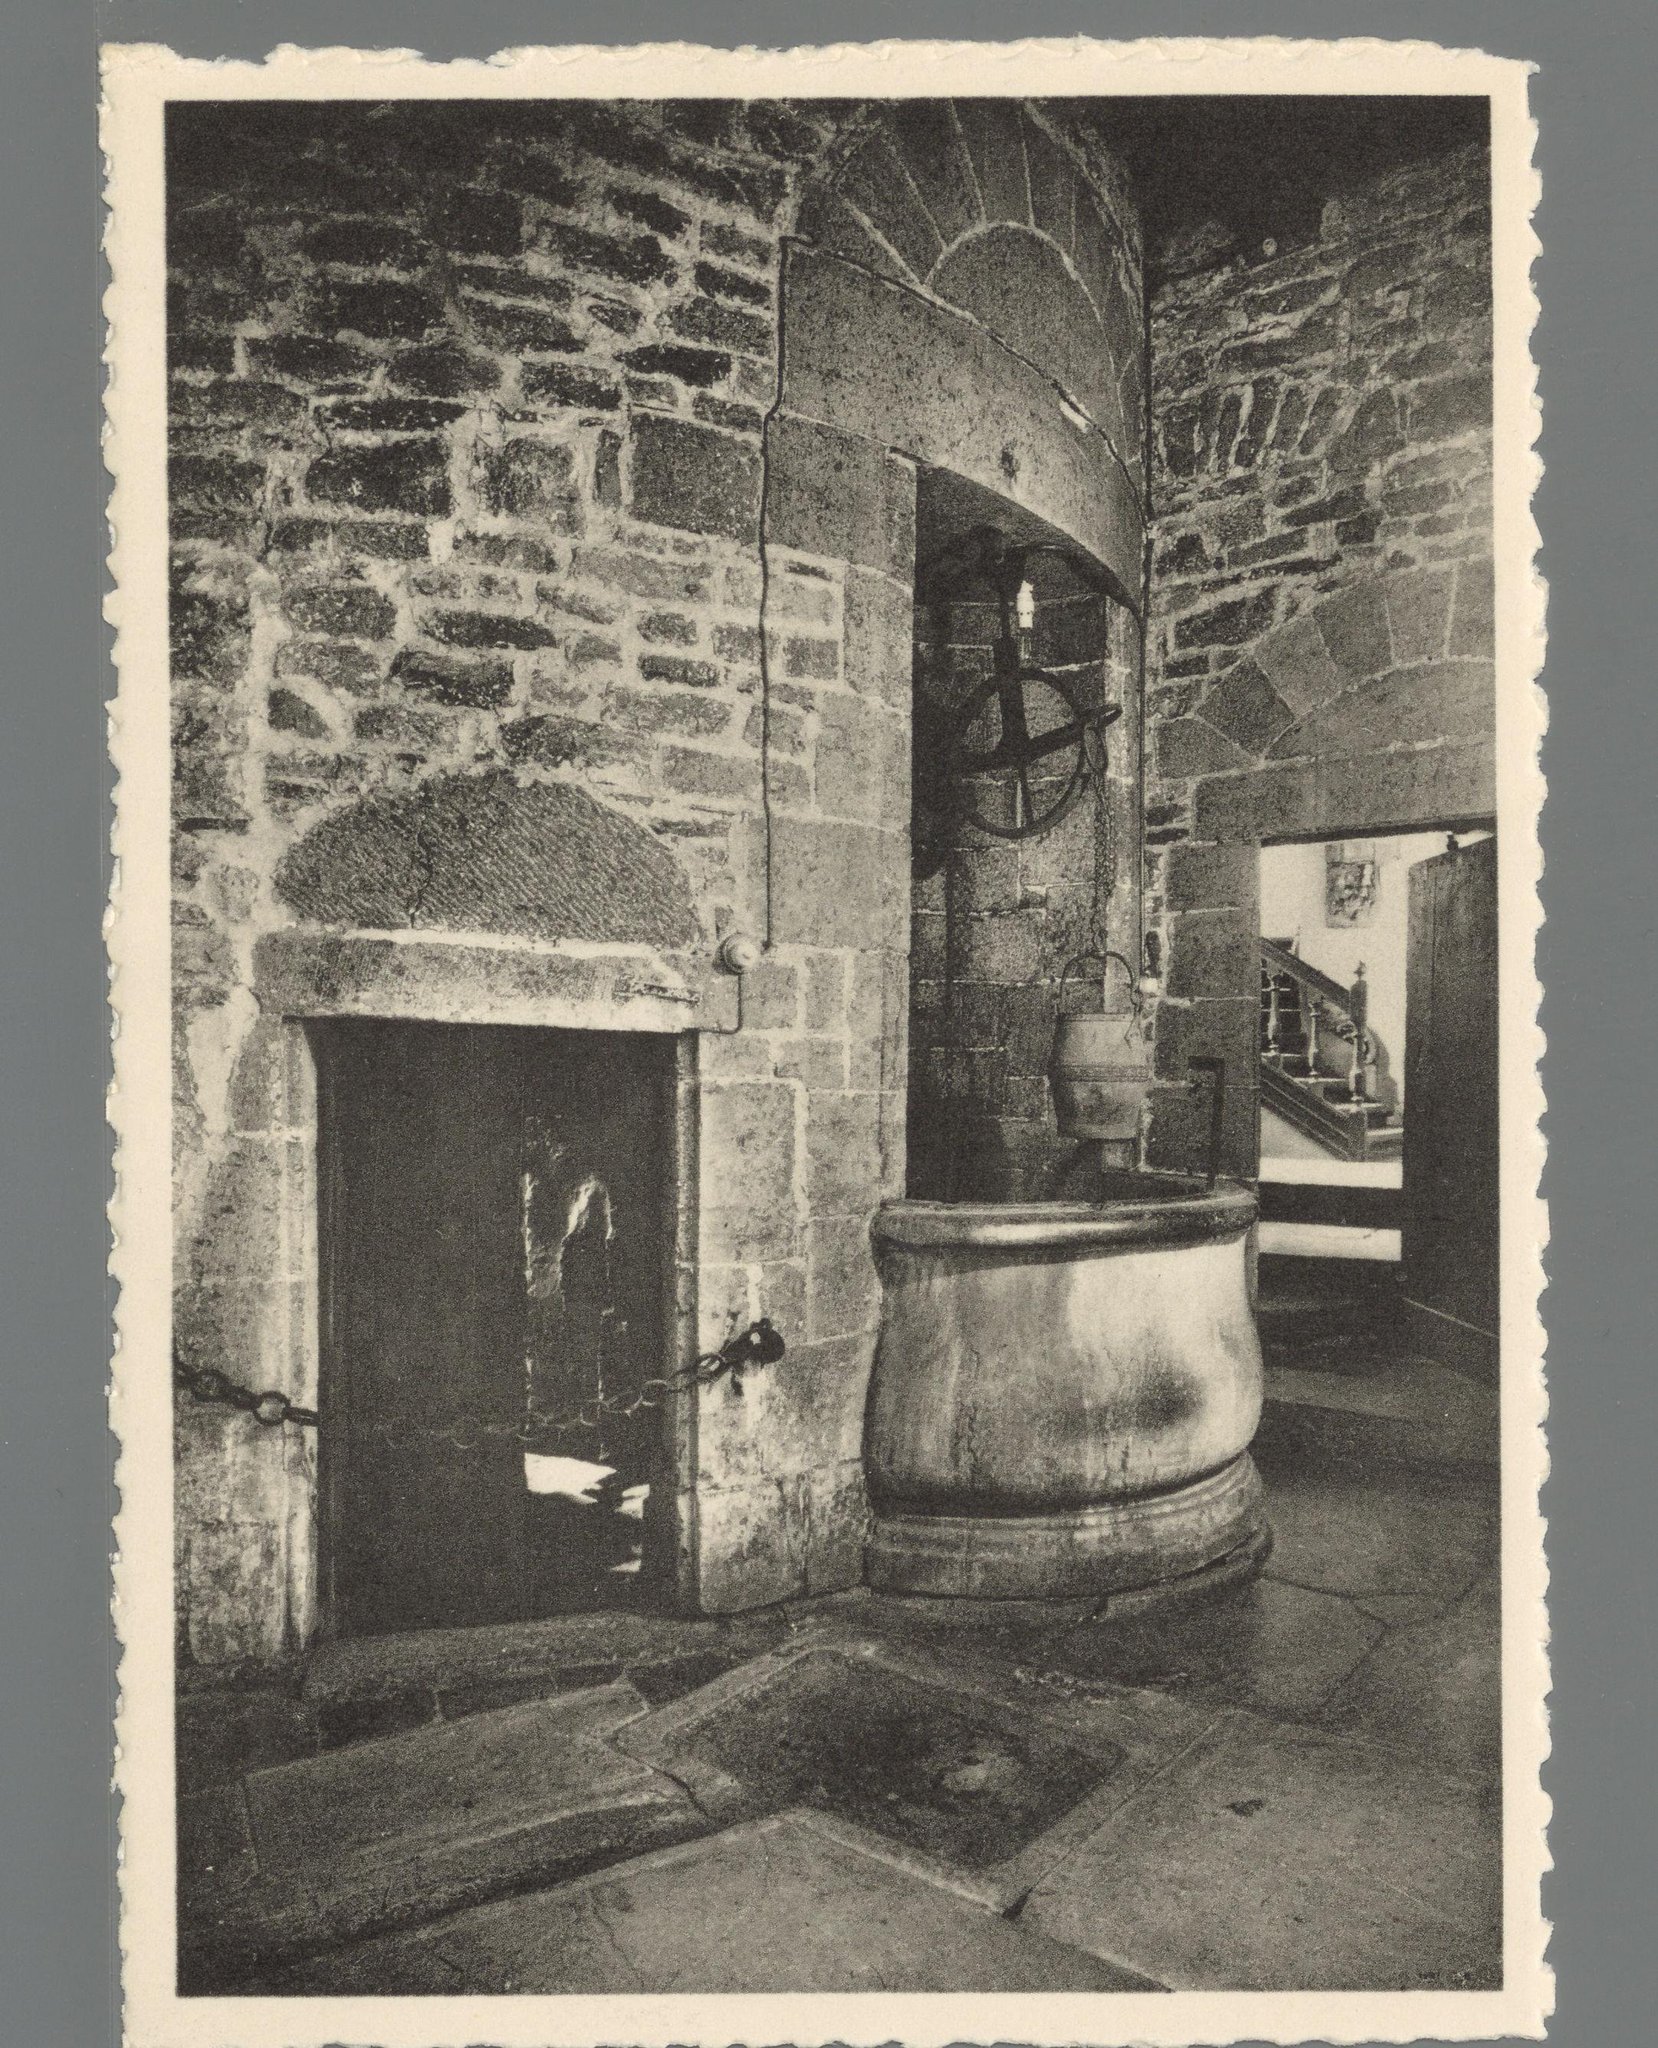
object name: photomechanical print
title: Château d'Ecausinnes-Lalaing (XIVe siècle)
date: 1913-1950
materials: cardboard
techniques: photograph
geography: brussels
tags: castle, permanent exhibition, museum, interior ~ representation of a building